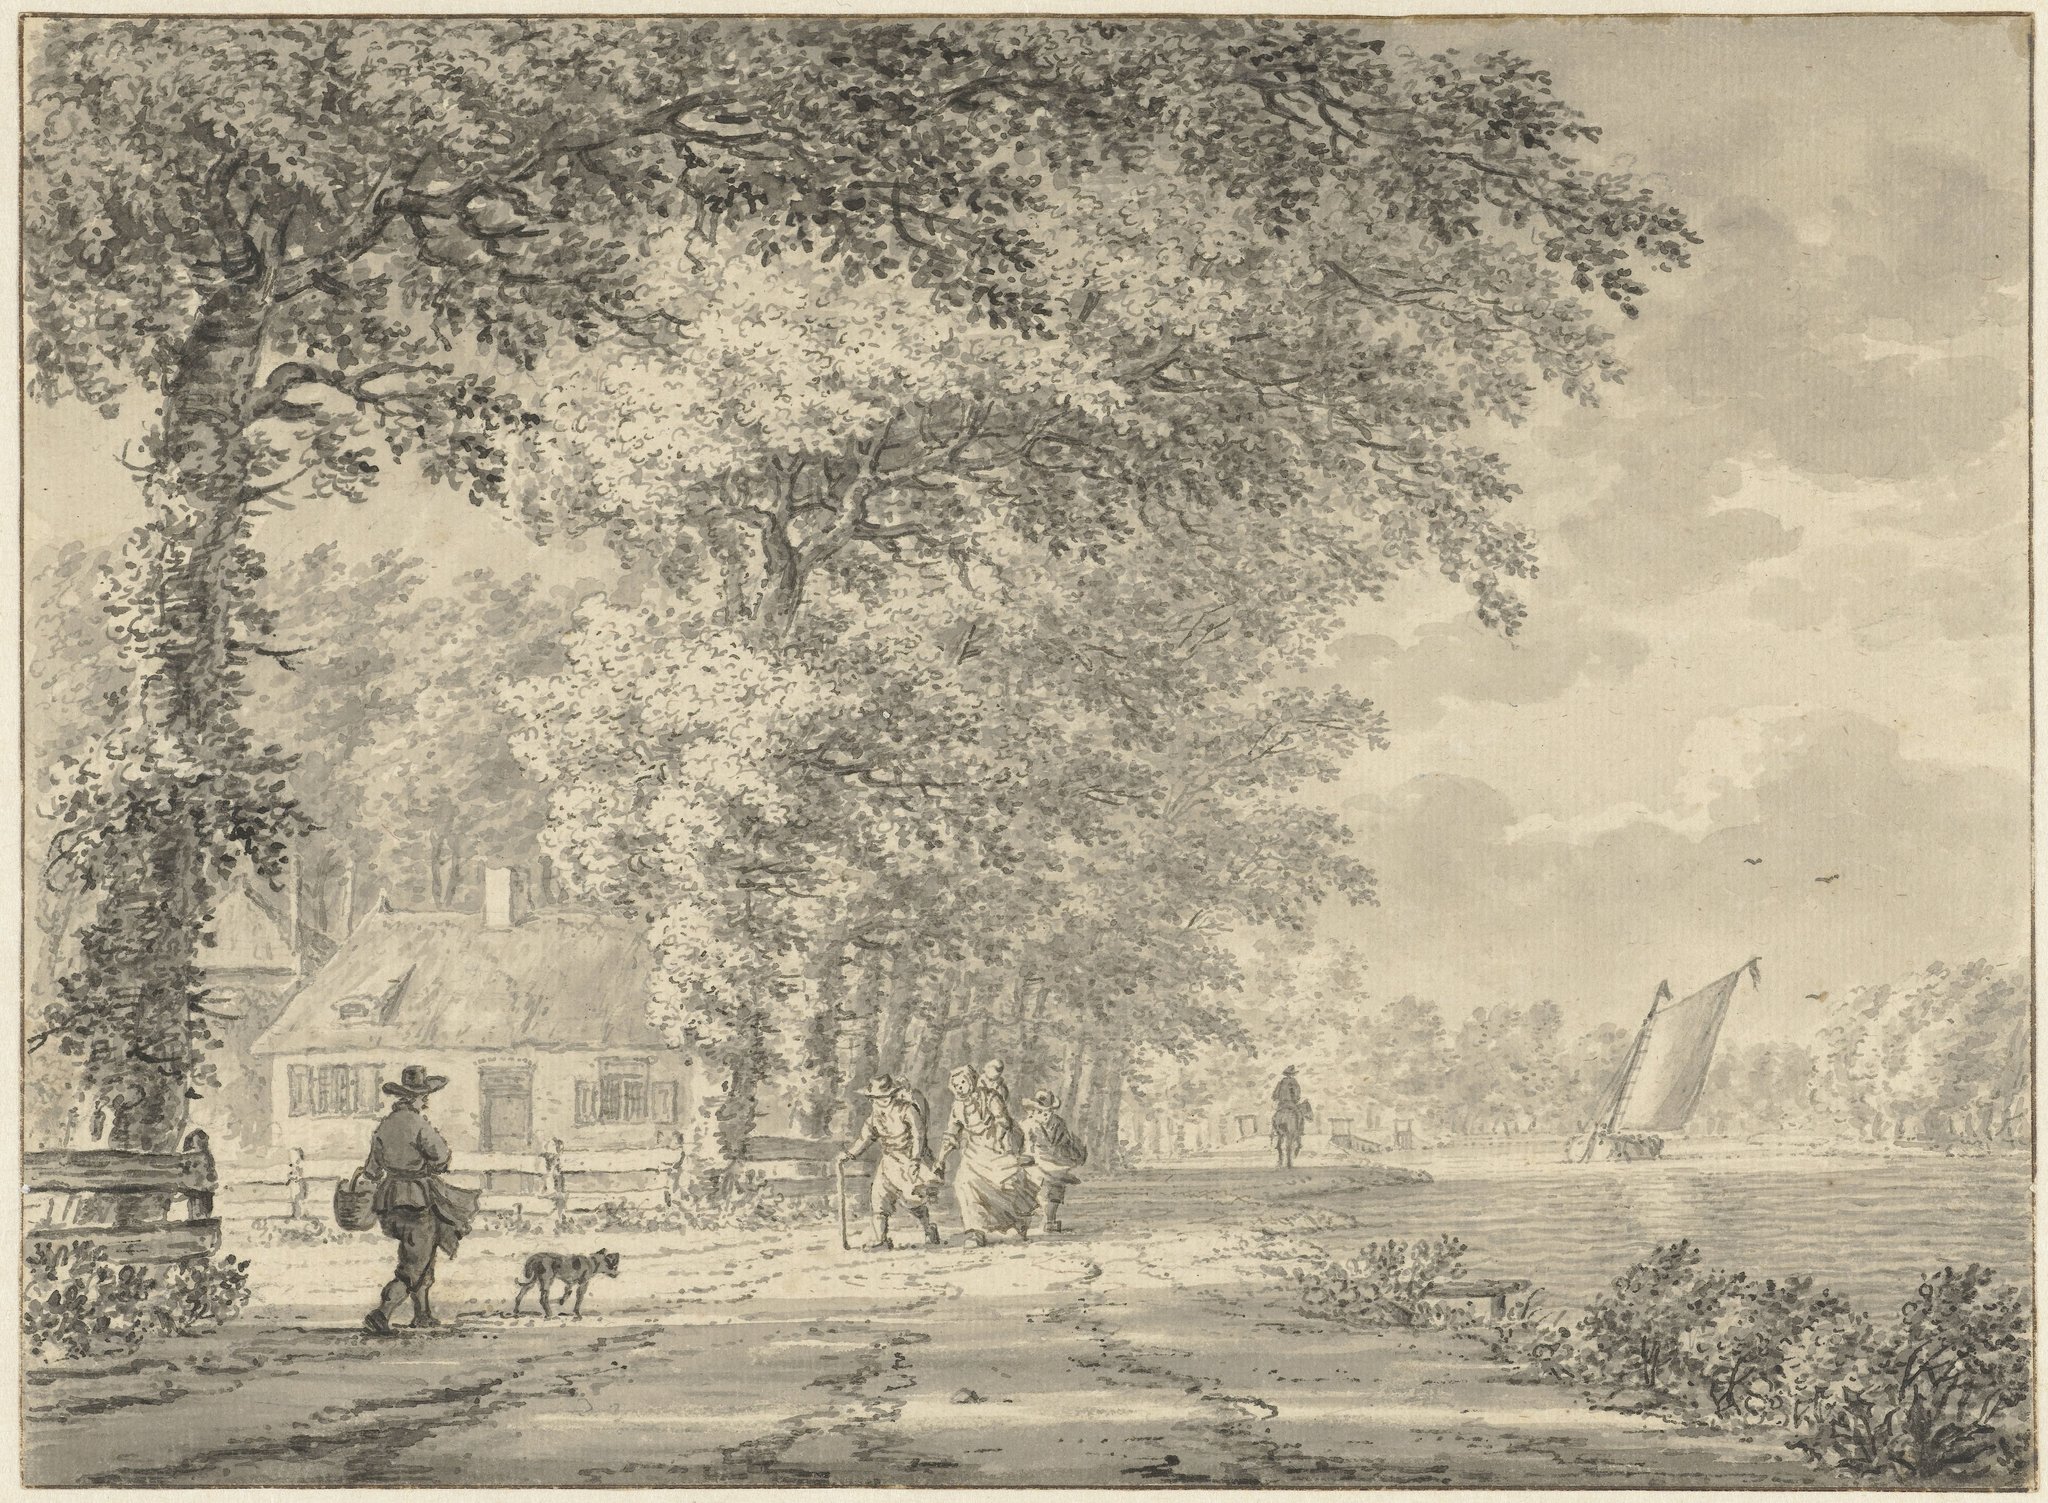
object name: drawing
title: Landschap met weg langs een kanaal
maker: johann goll van frankenstein (i)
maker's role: amateurtekenaar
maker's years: 1722-1785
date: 1732-1785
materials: ink, paper, pencil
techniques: brush, pen